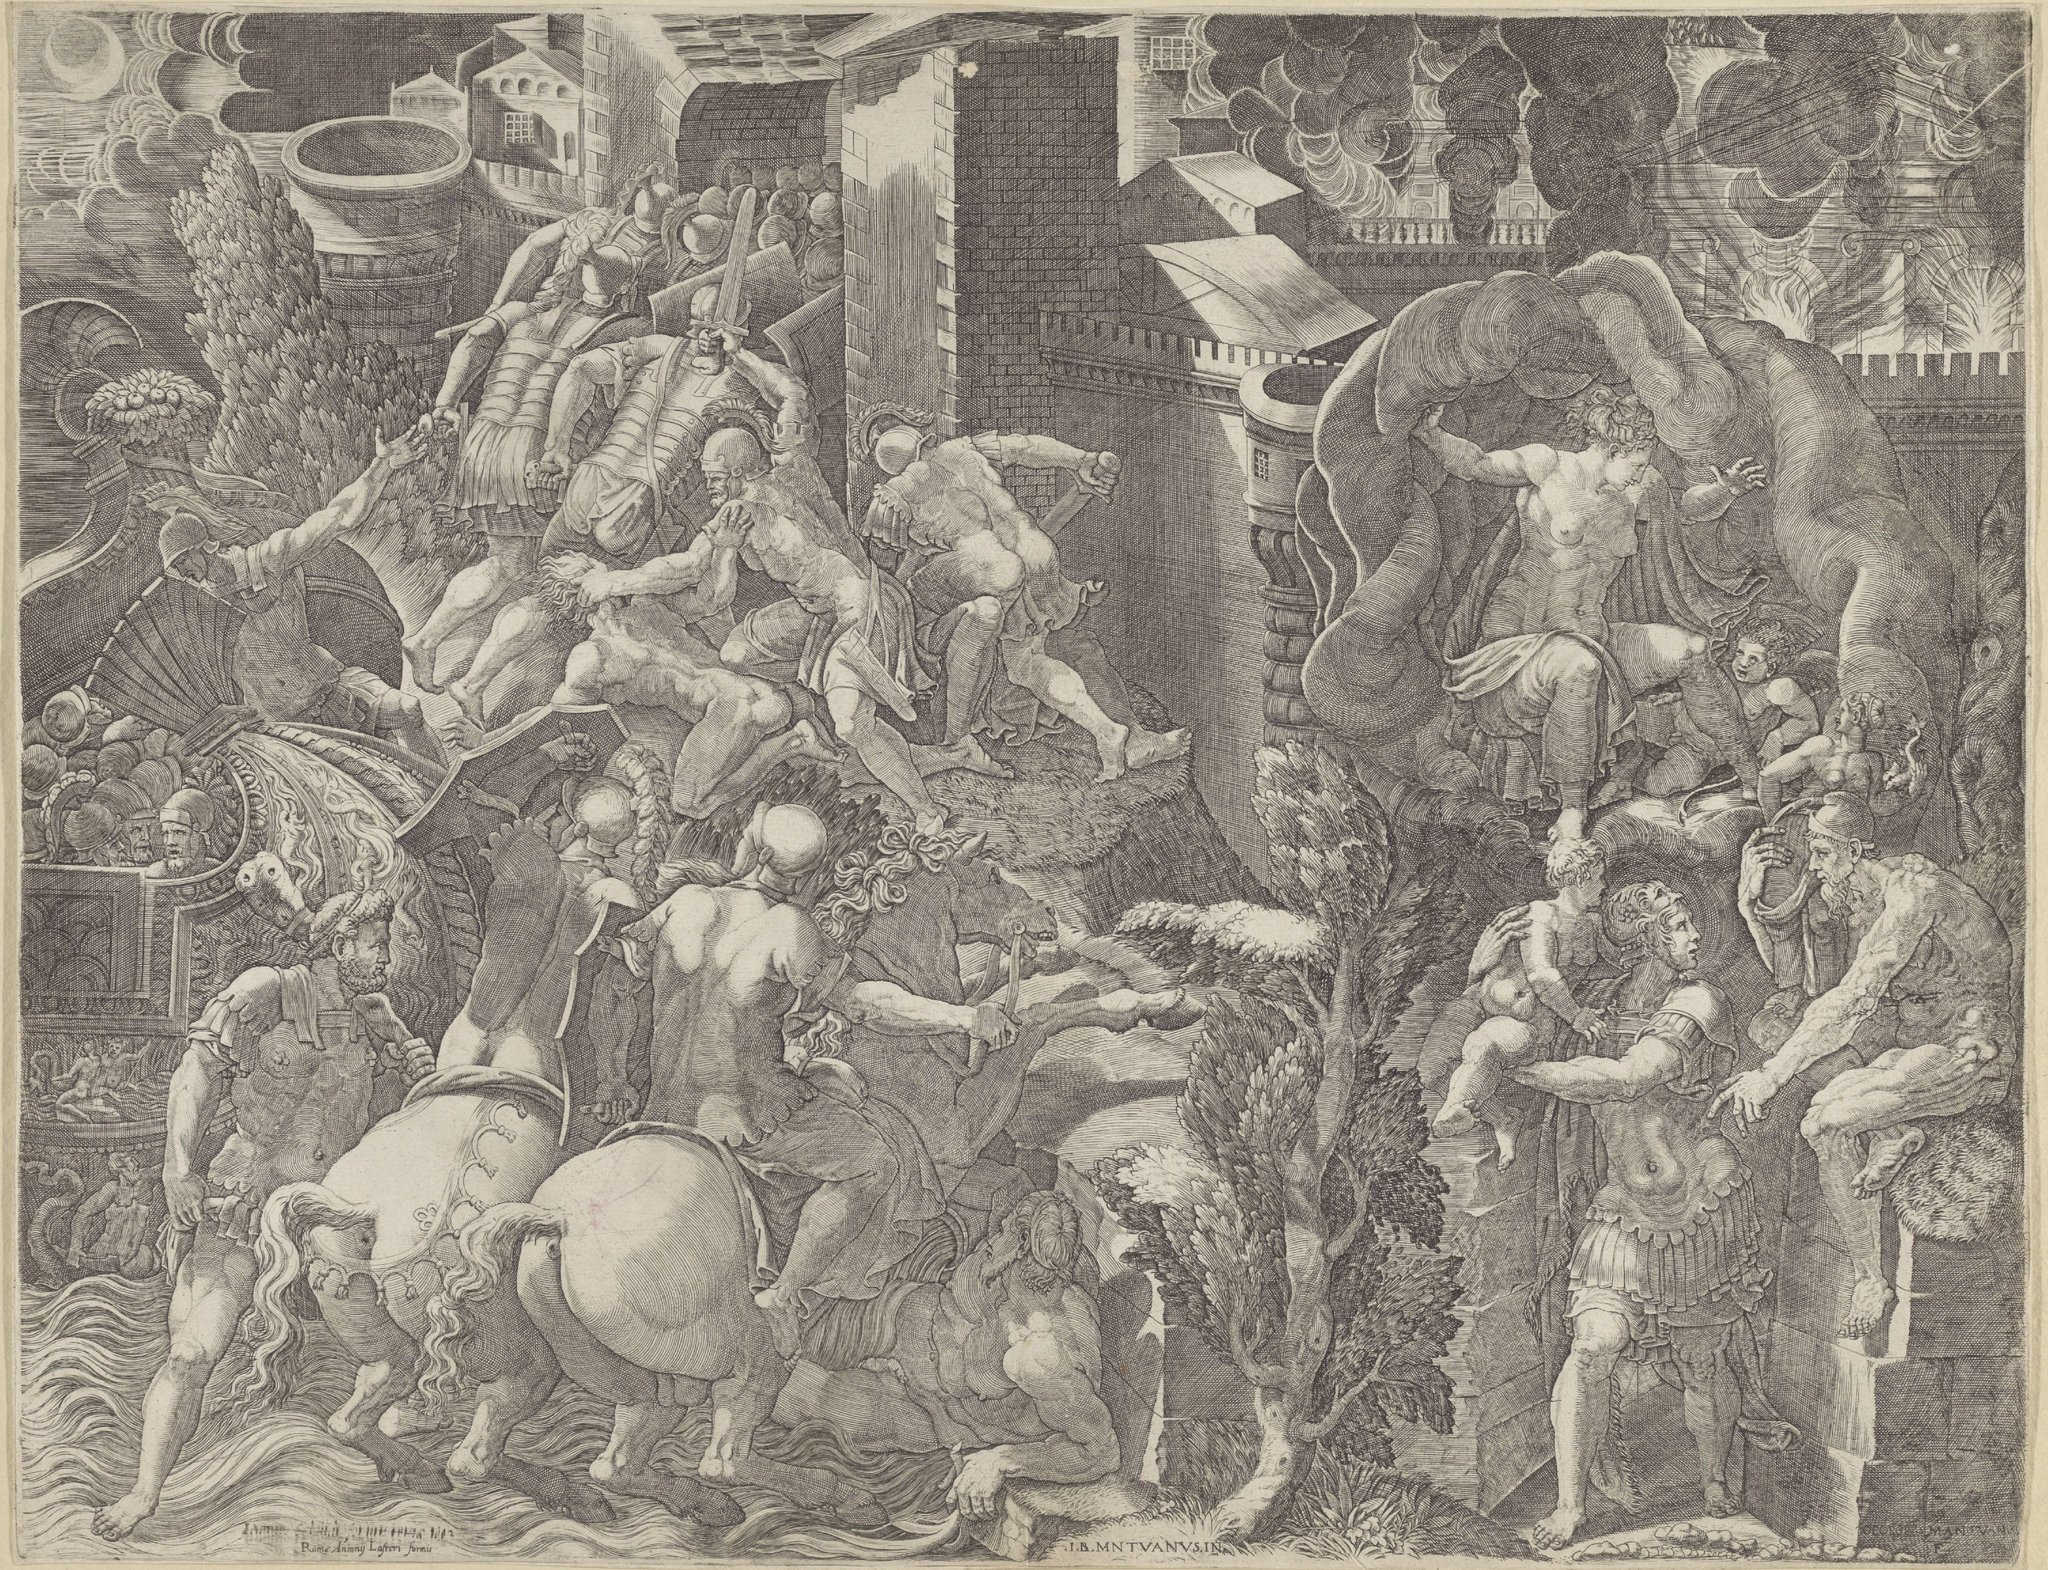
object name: print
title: Val van Troje en de ontsnapping van Aeneas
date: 1530-1582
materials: paper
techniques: engraving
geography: italy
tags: 'pius aeneas': aeneas, leading ascanius, escapes from burning troy, carrying his father anchises with the penates; his wife creusa, who sets out with them, is lost on the way, the soldier; the soldier's life, the fall of troy; troy burning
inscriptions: collector's mark: Lugt 11, collector's mark: Lugt 10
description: Het Griekse leger stormt Troje binnen. Rechts de brandende stad Troje. Op de voorgrond rechts Aeneas die samen met Anchises en Ascanius de stad uit vlucht.